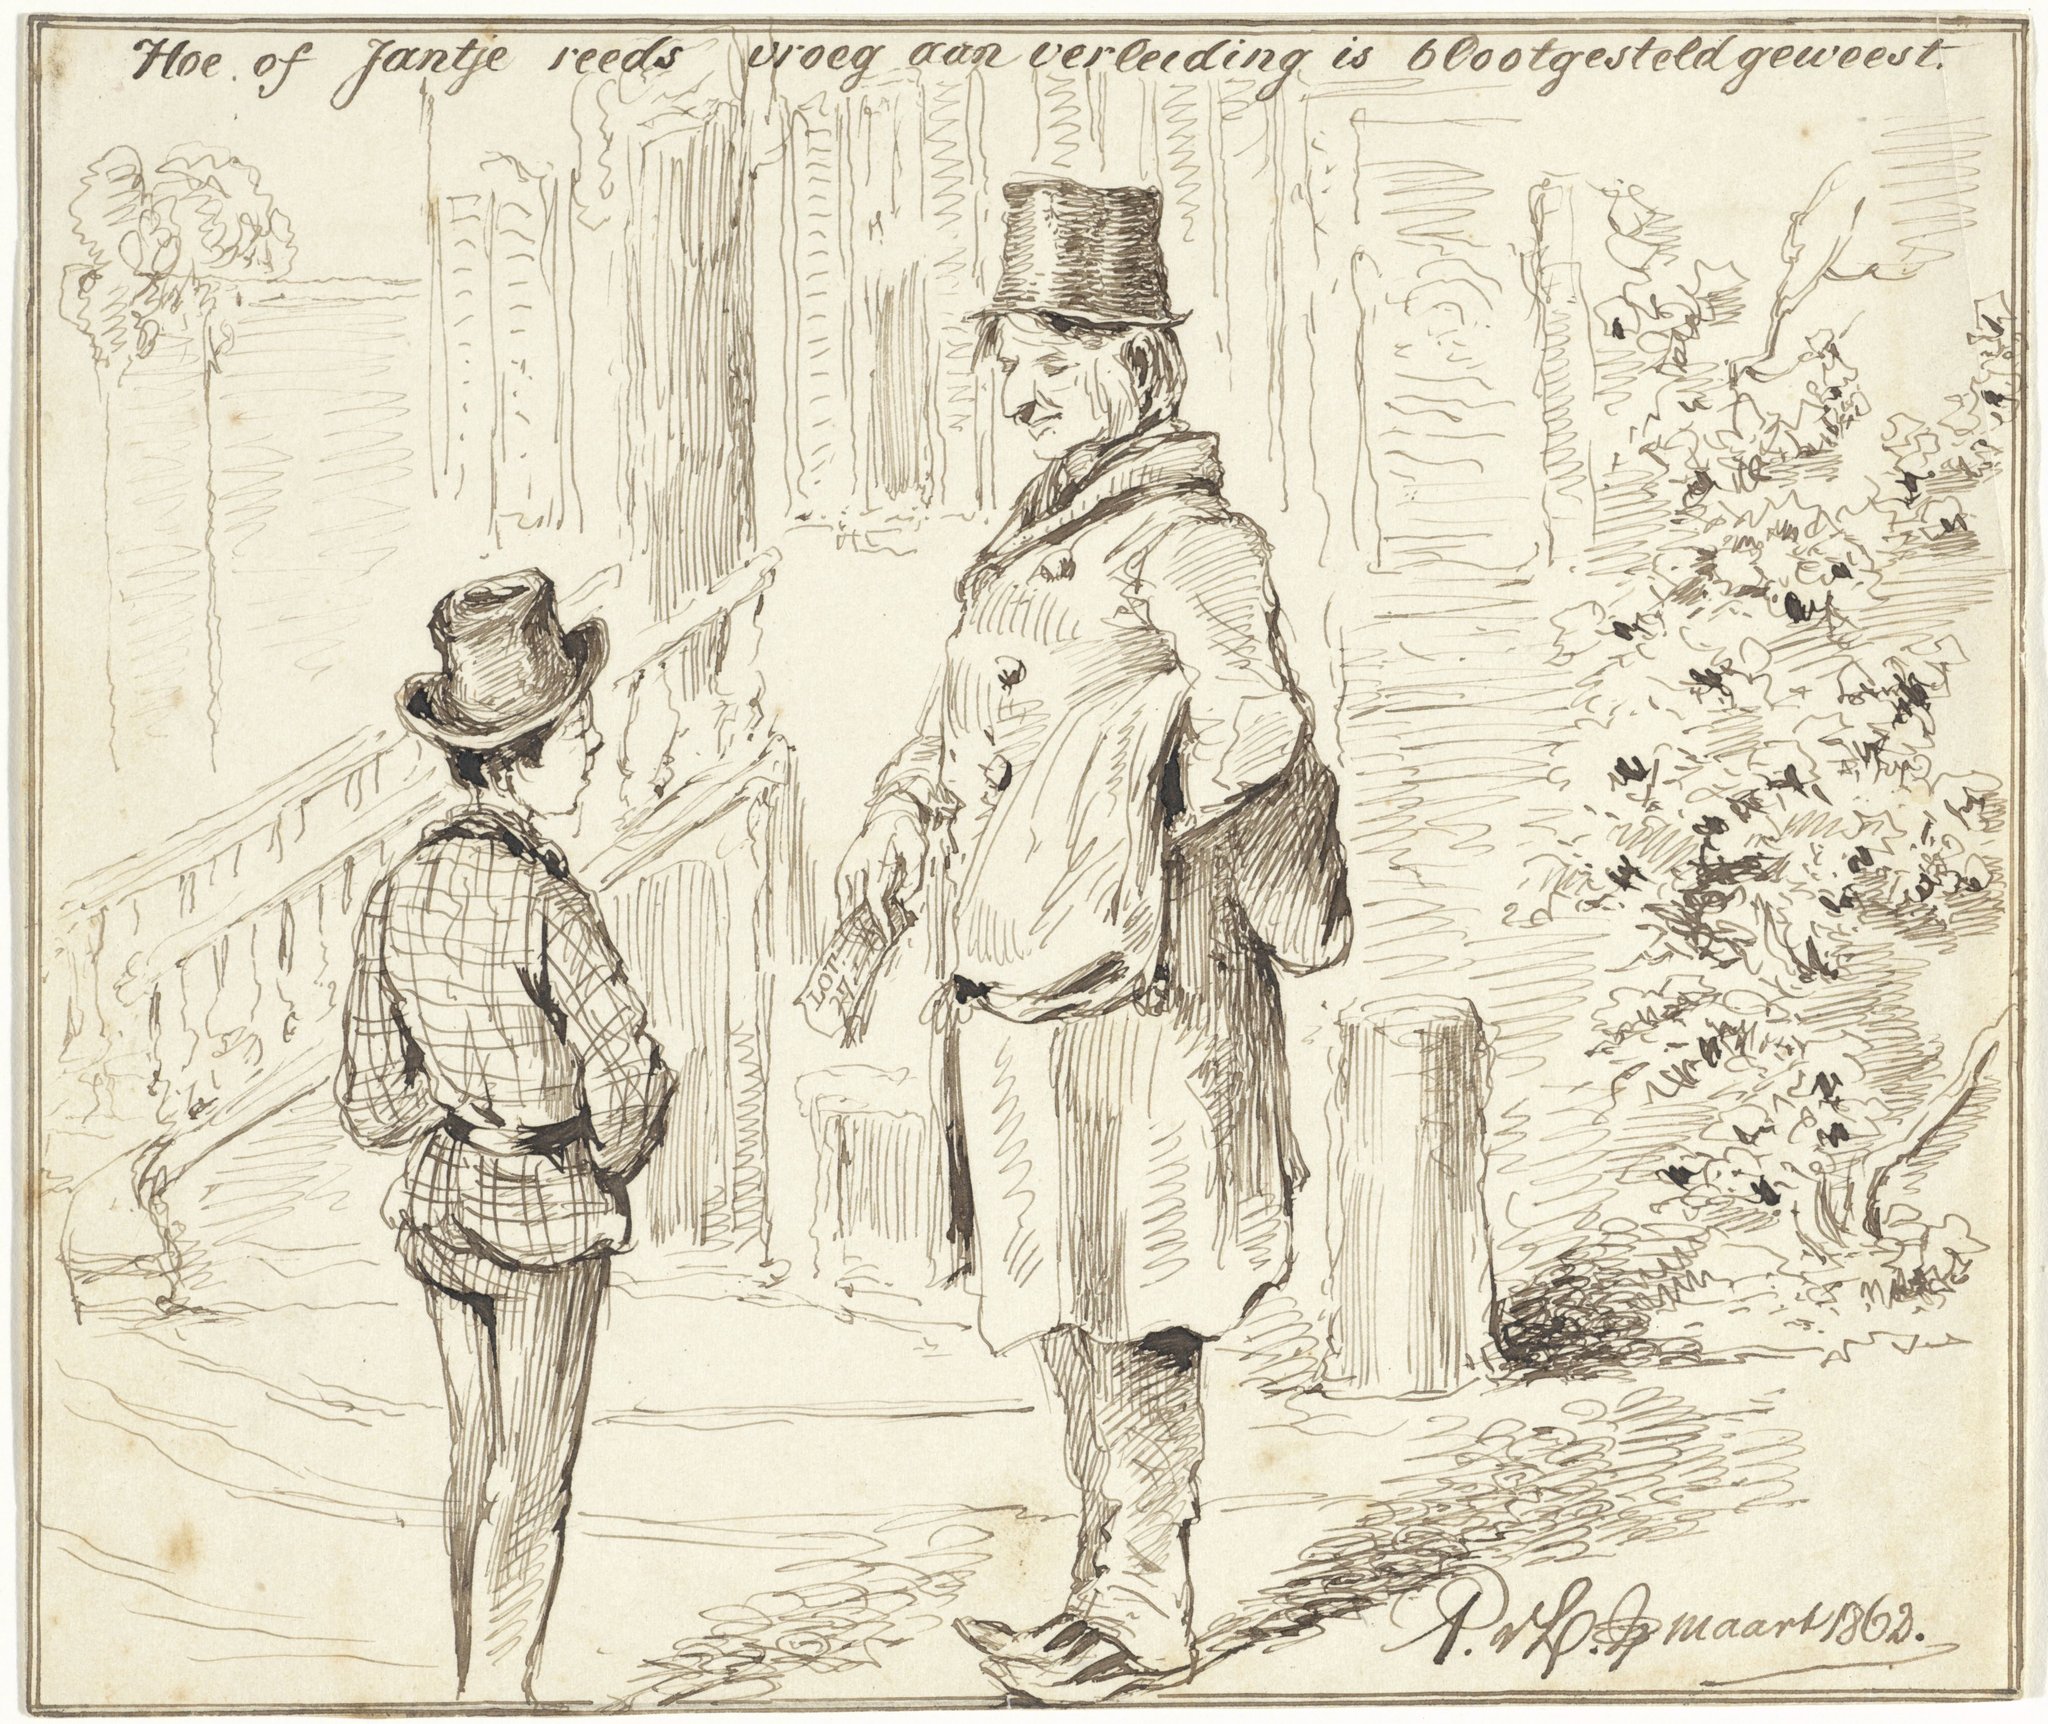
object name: drawing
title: Verhaal van de jongen Jantje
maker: pieter van loon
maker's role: draughtsman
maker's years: 1801-1873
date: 1803-1862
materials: ink, paper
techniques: pen